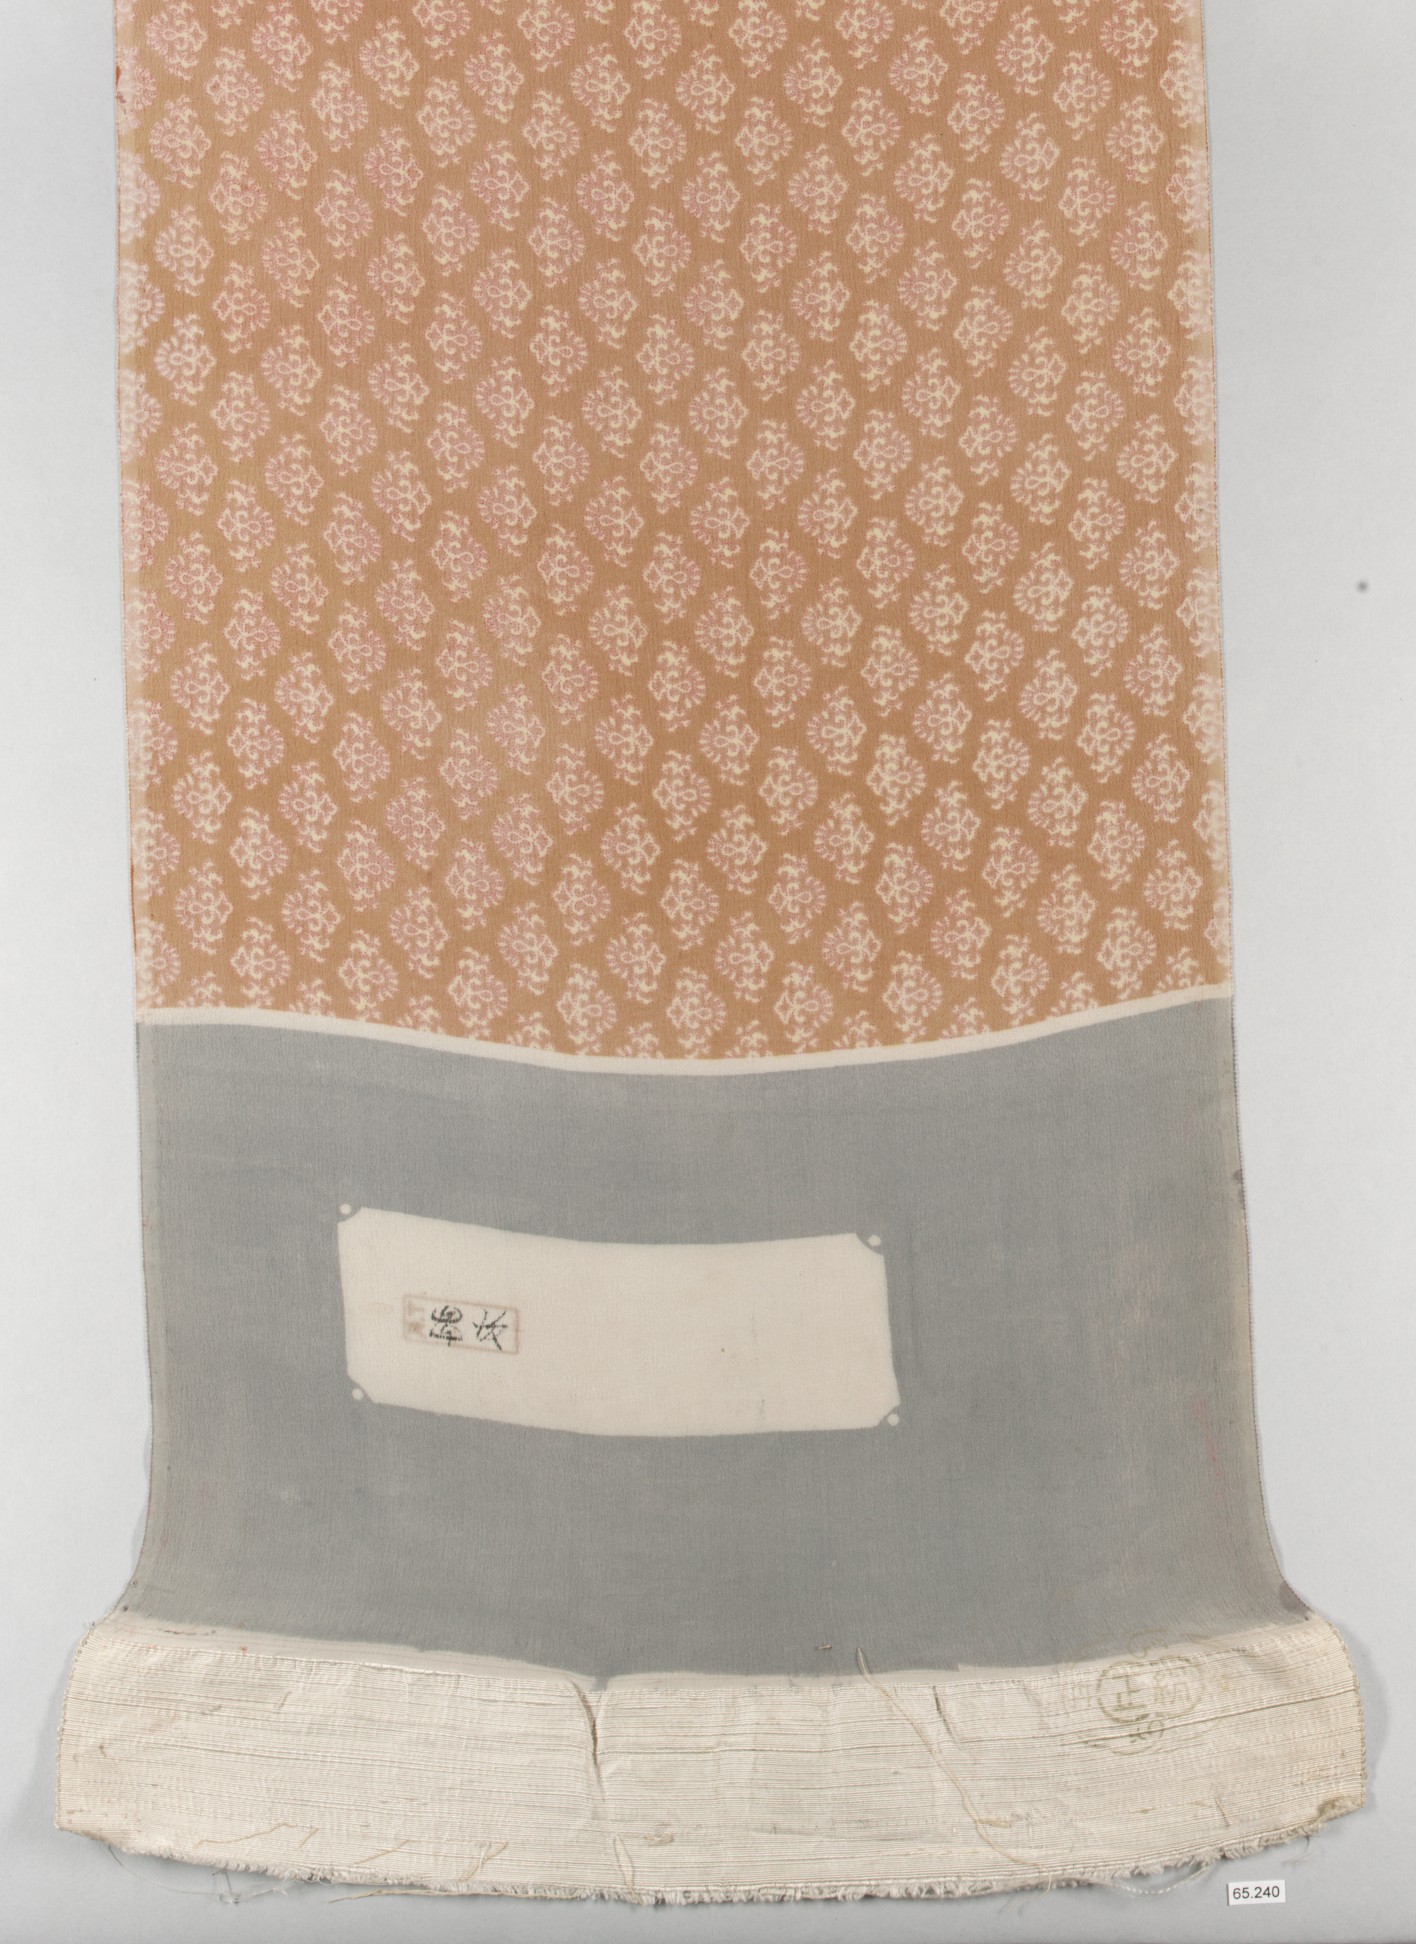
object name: length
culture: japanese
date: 1901-1950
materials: silk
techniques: weave